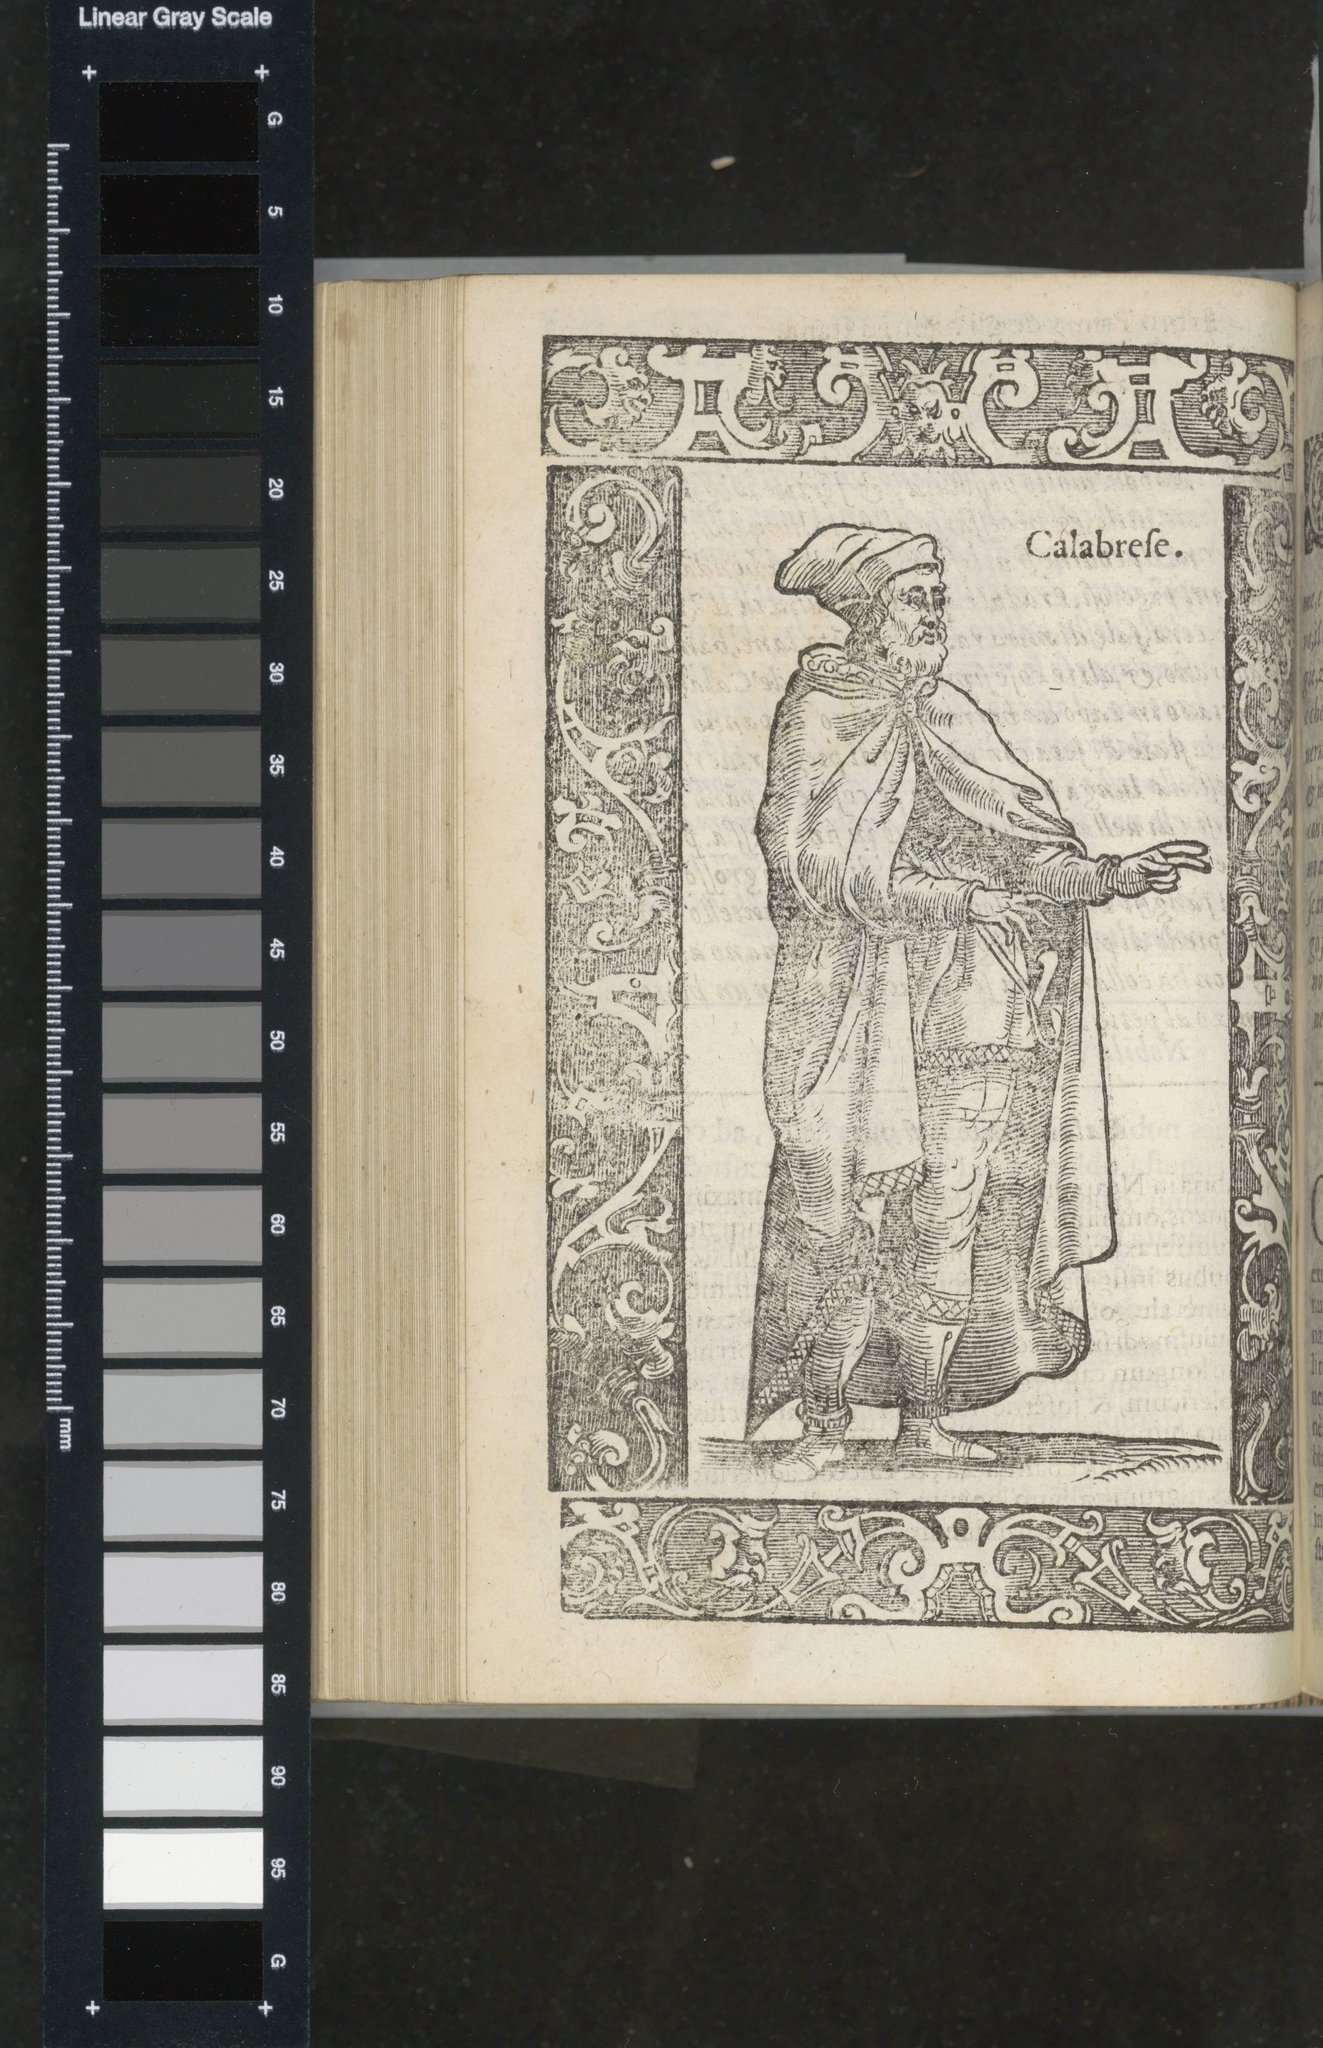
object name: costume print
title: Habiti antichi, et moderni di tutto il mondo...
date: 1598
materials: paper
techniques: woodcut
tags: fashion plates